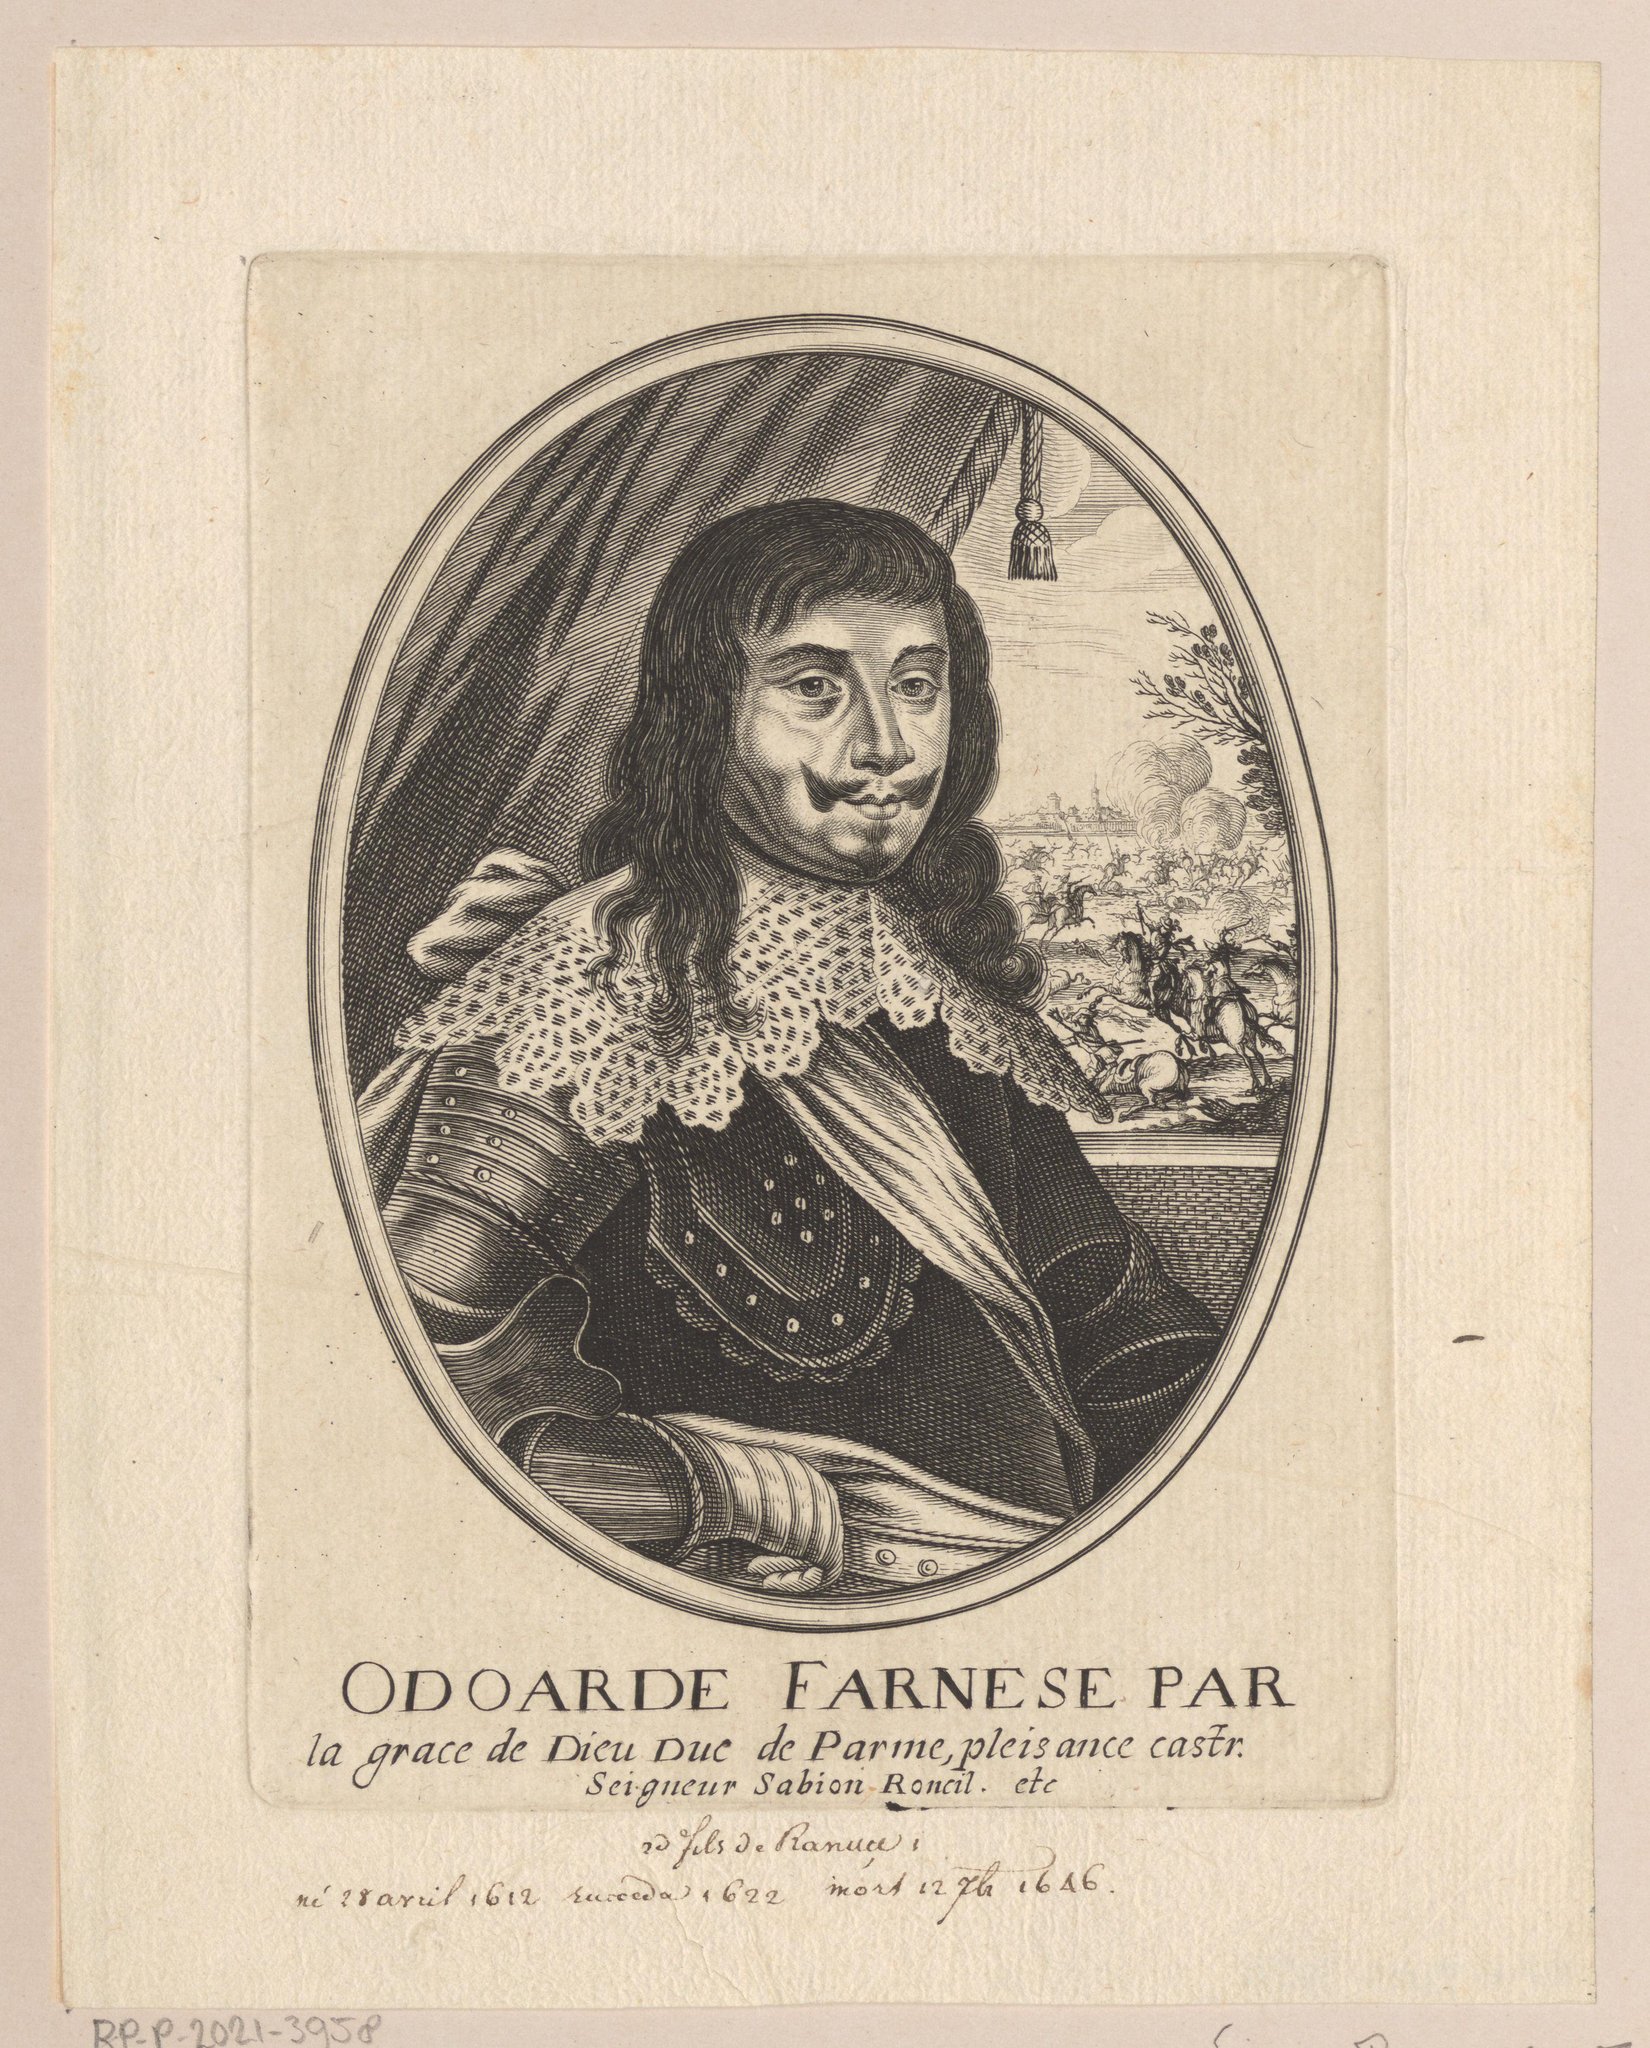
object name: print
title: Portret van Odoardo Farnese, hertog van Parma en Piacenza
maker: Anonymous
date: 1622-1749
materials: paper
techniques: engraving, etching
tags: historical persons, battle